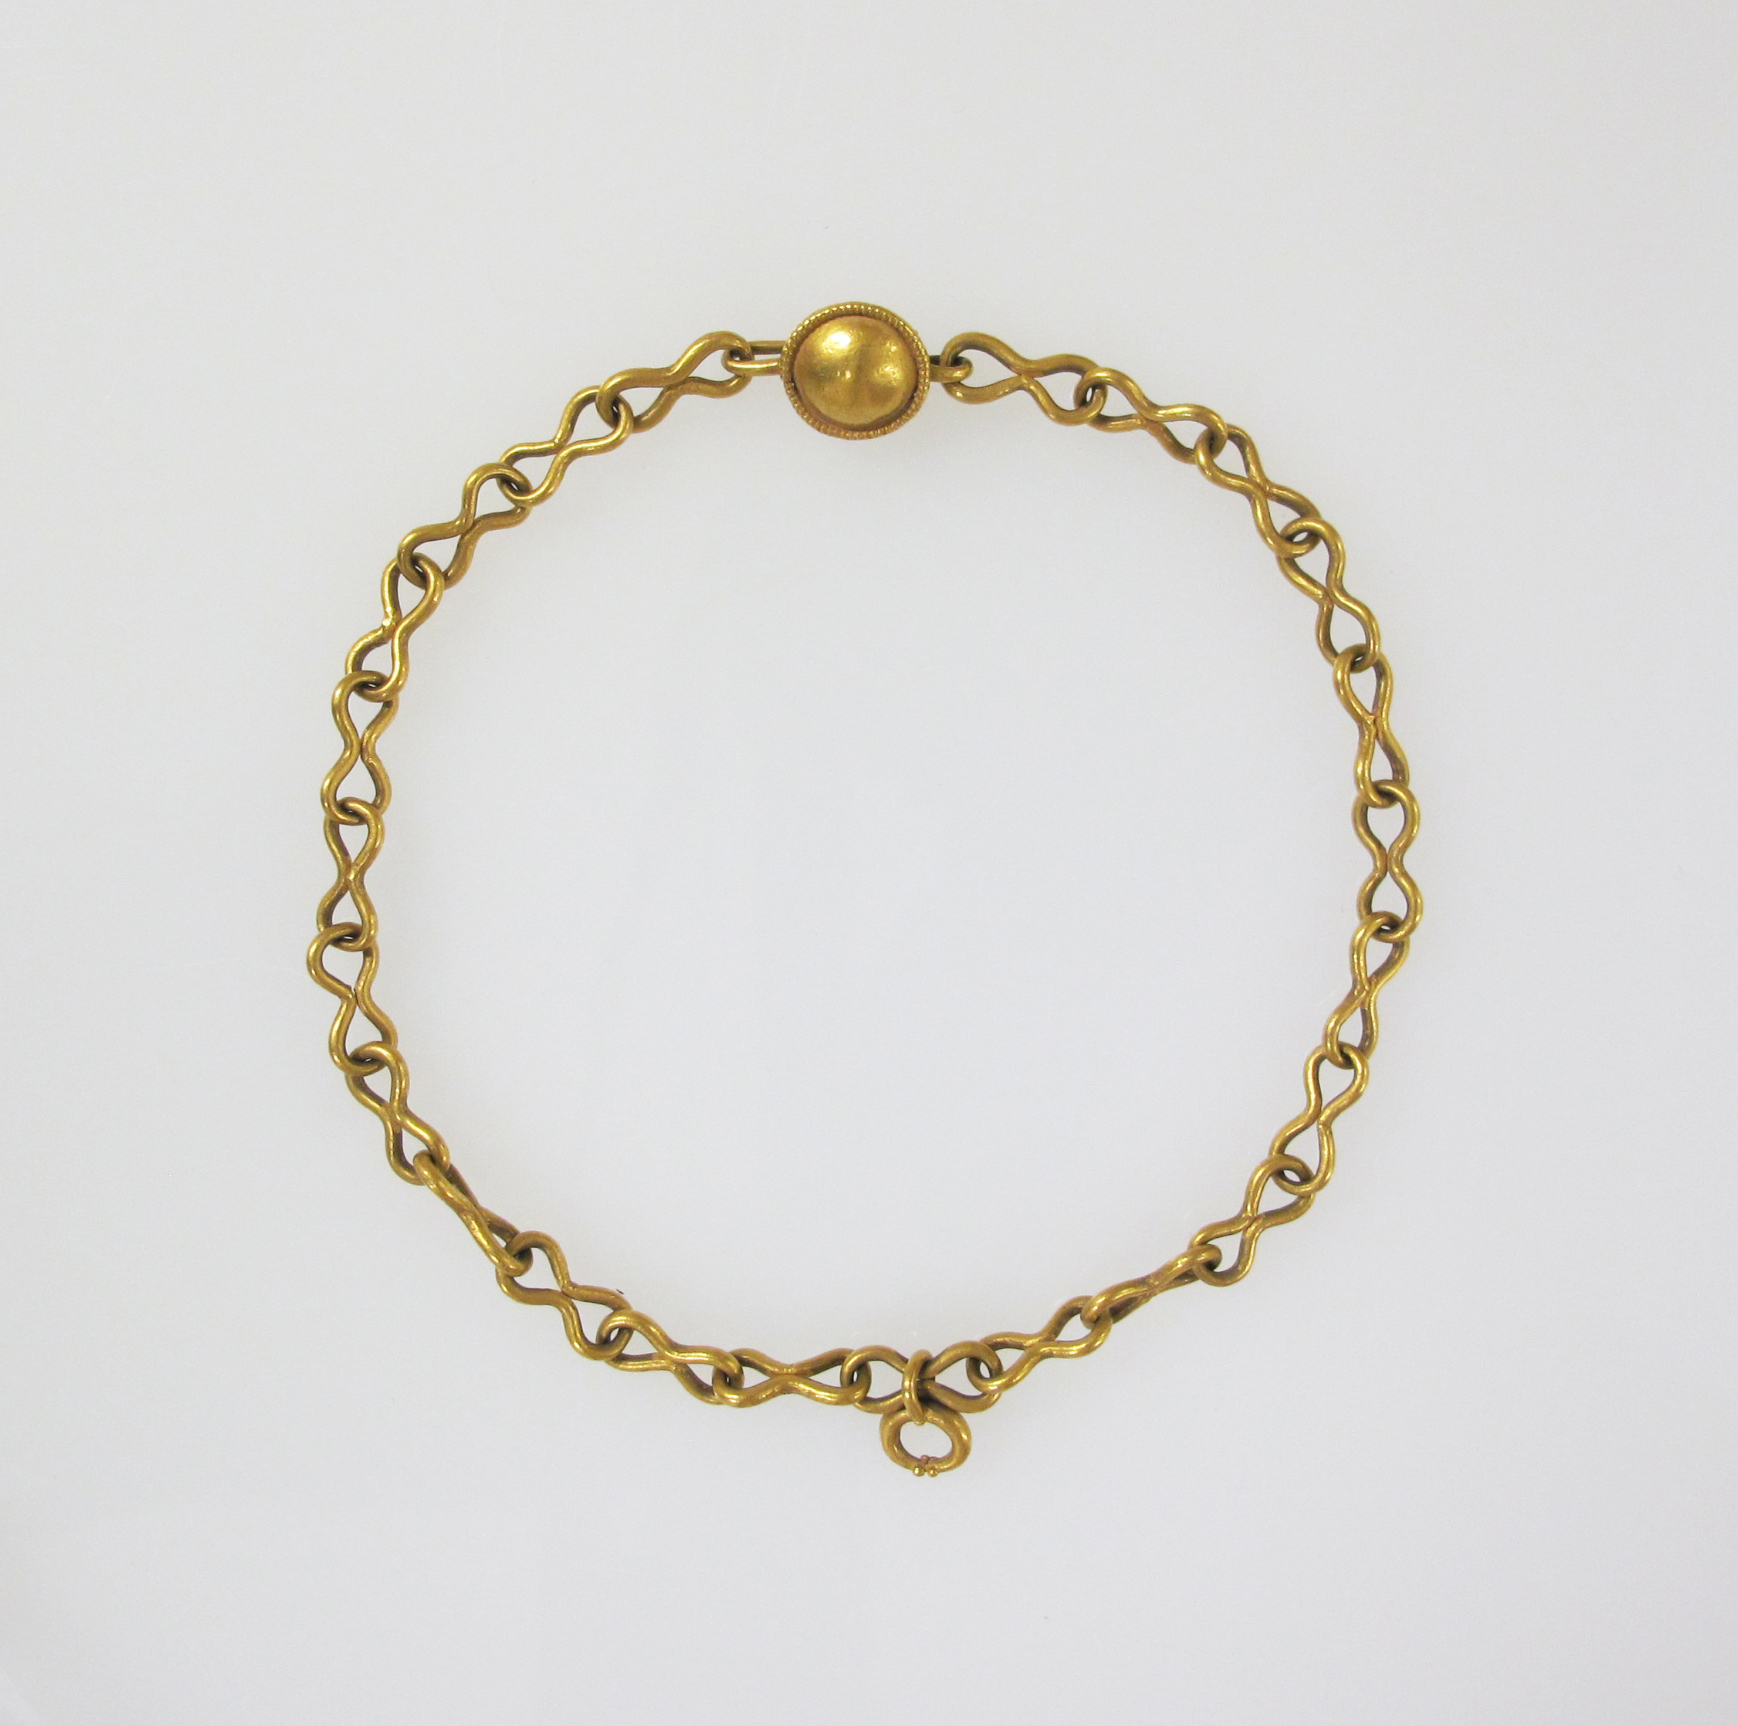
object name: necklace, chain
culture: roman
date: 1-100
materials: gold